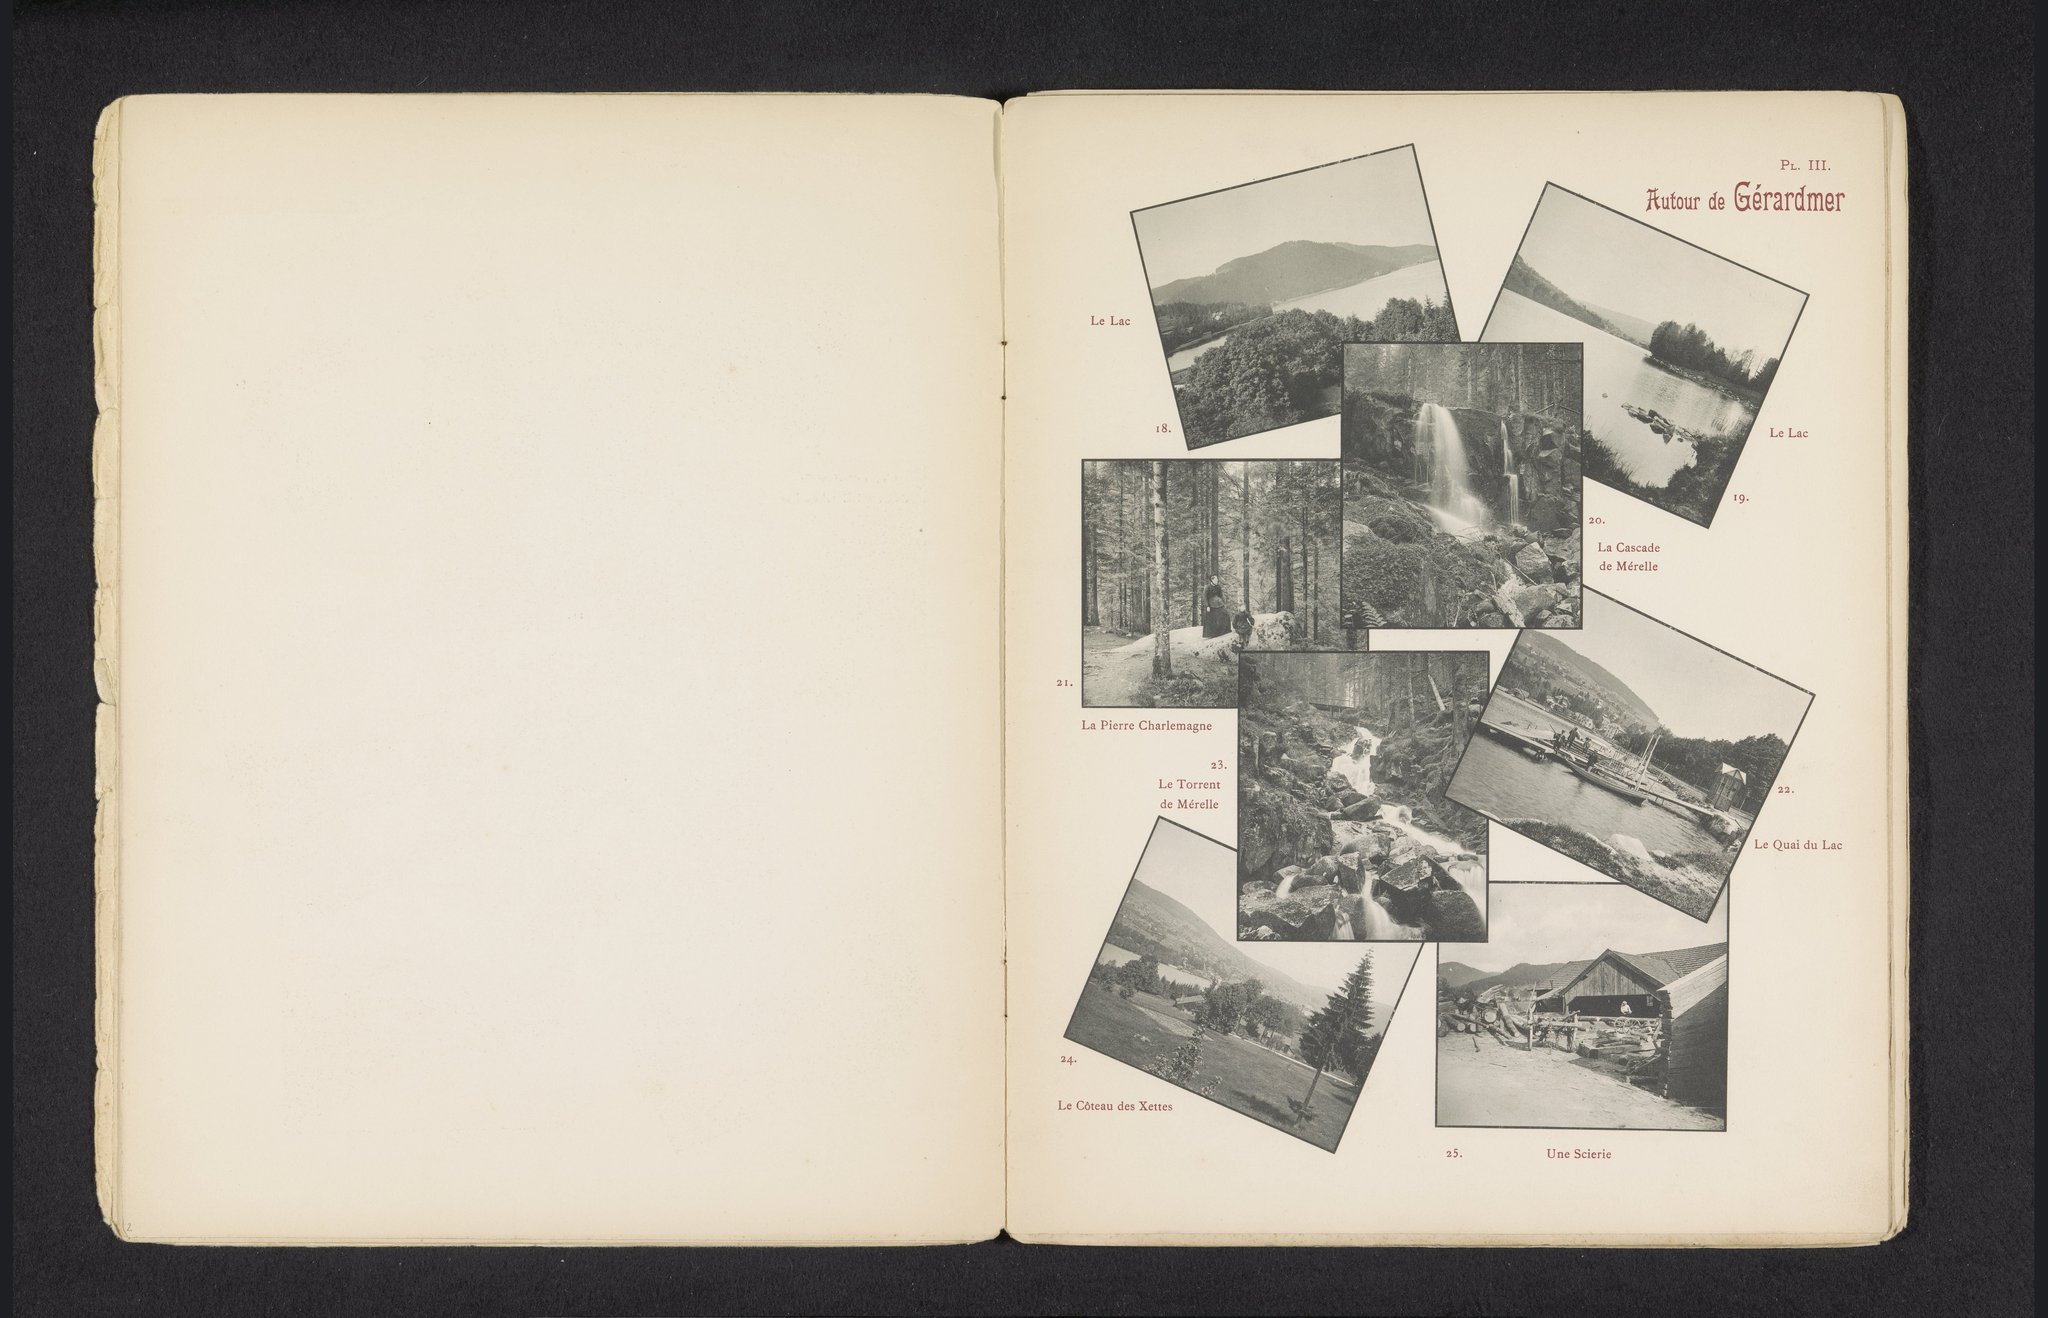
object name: page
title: Autour de Gérardmer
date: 1888-1898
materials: paper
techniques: photograph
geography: vosges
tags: waterfall, quay, wood and park (as places of recreation)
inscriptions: number: ‘Pl. III.’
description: Nummers 18 tot en met 25: Tweemaal het meer van Gérardmer, cascade de Mérelle , een steen in het bos, een aanlegsteiger in het meer van Gérardmer, een waterval, een gezicht op Les Xettes en een houtzagerij.